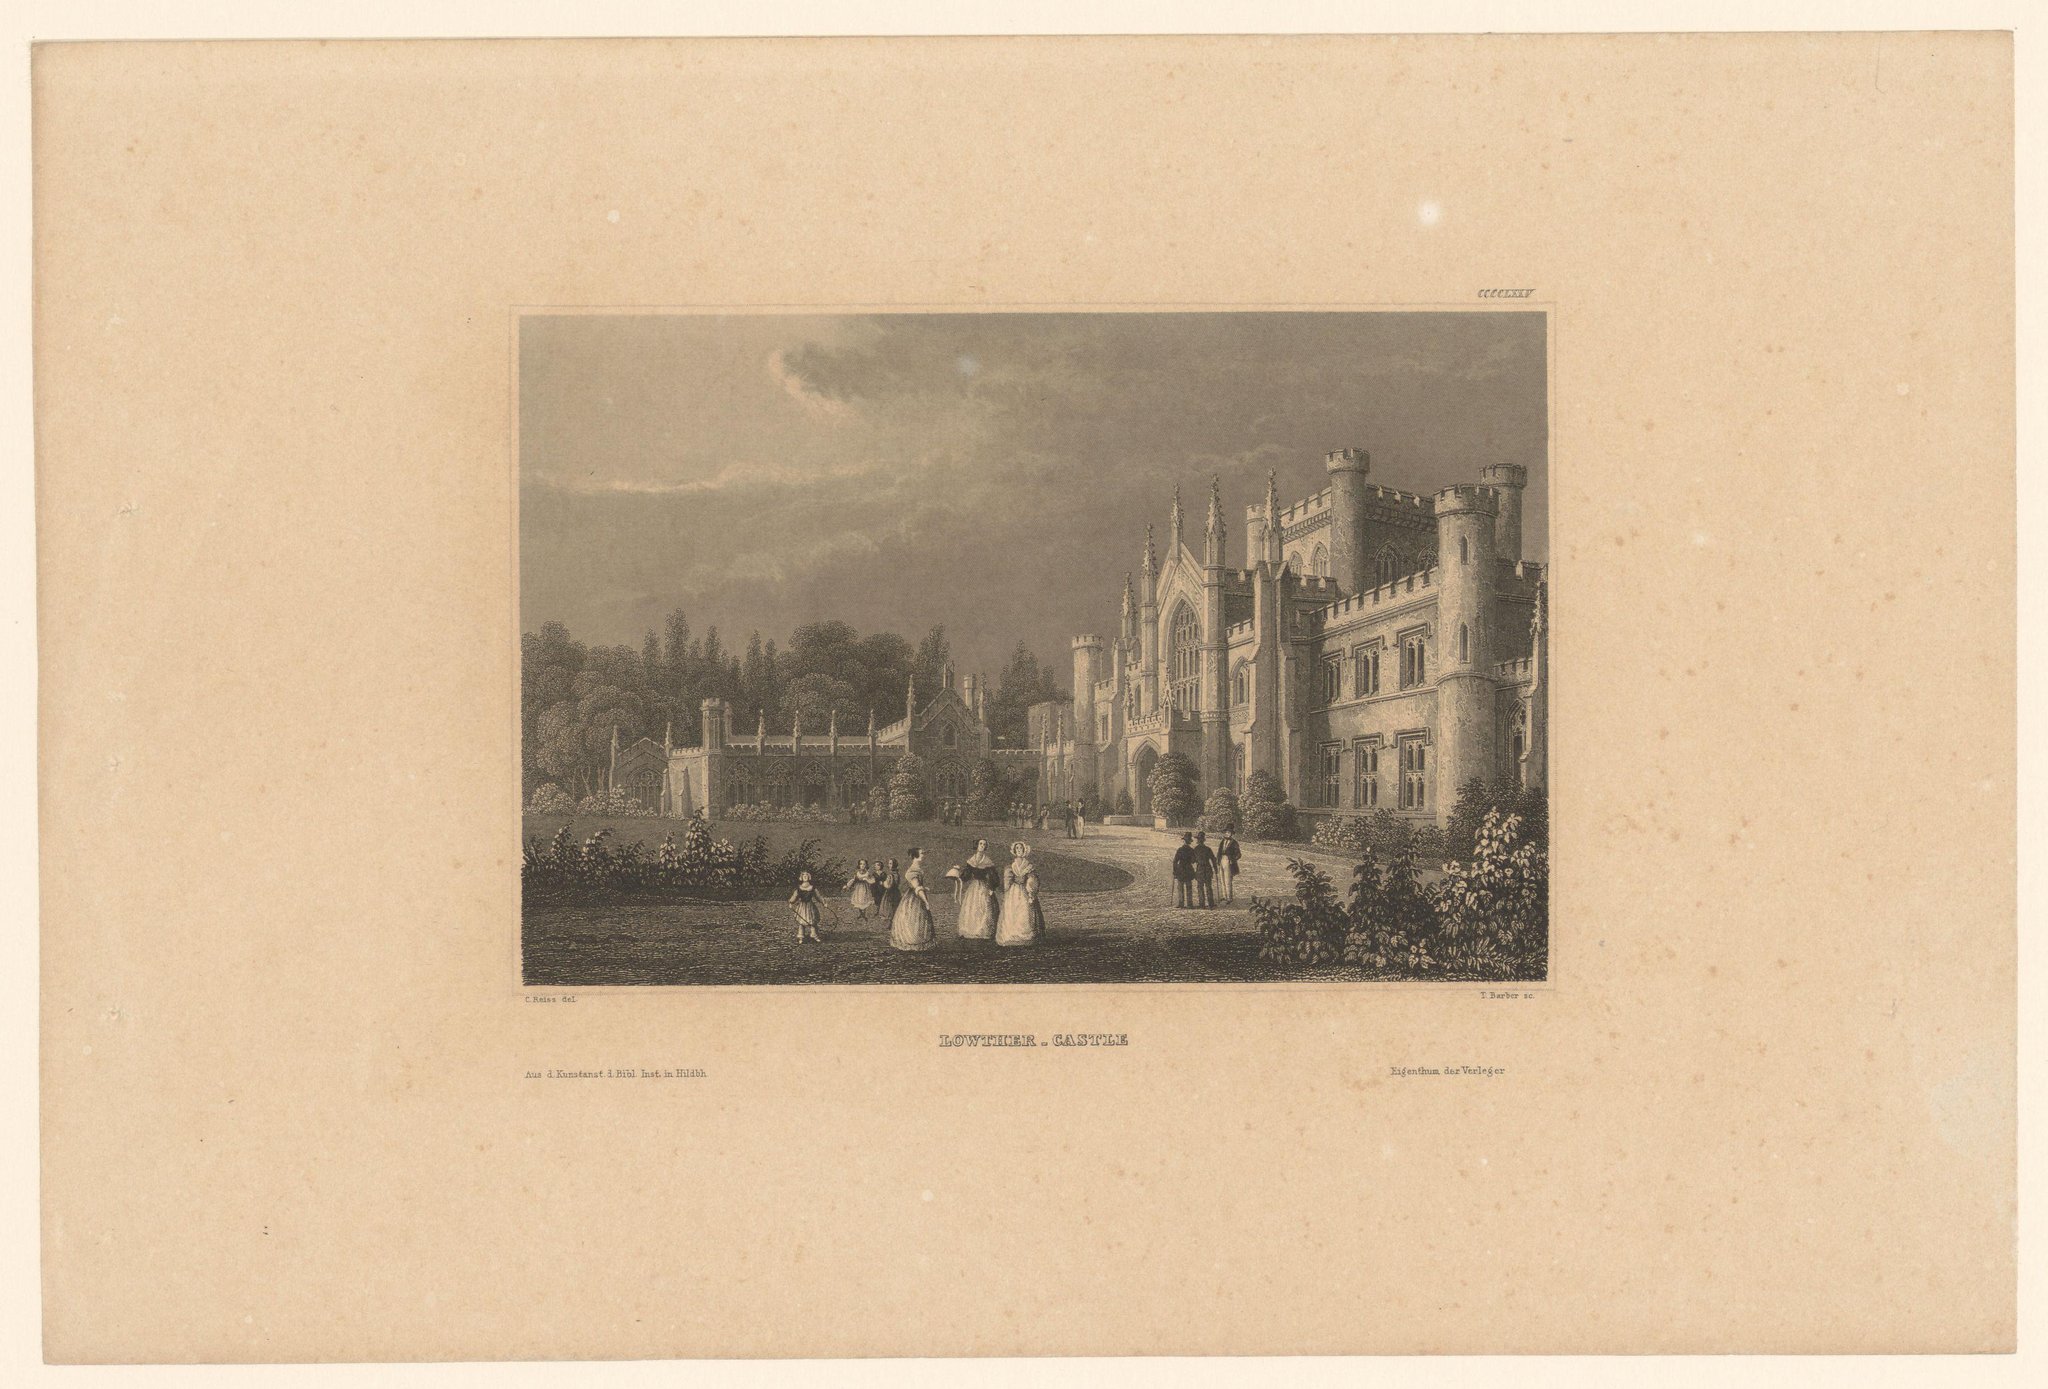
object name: print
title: Gezicht op Lowther Castle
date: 1828-1843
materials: paper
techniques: engraving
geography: england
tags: castle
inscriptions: collector's mark: Lugt 2228